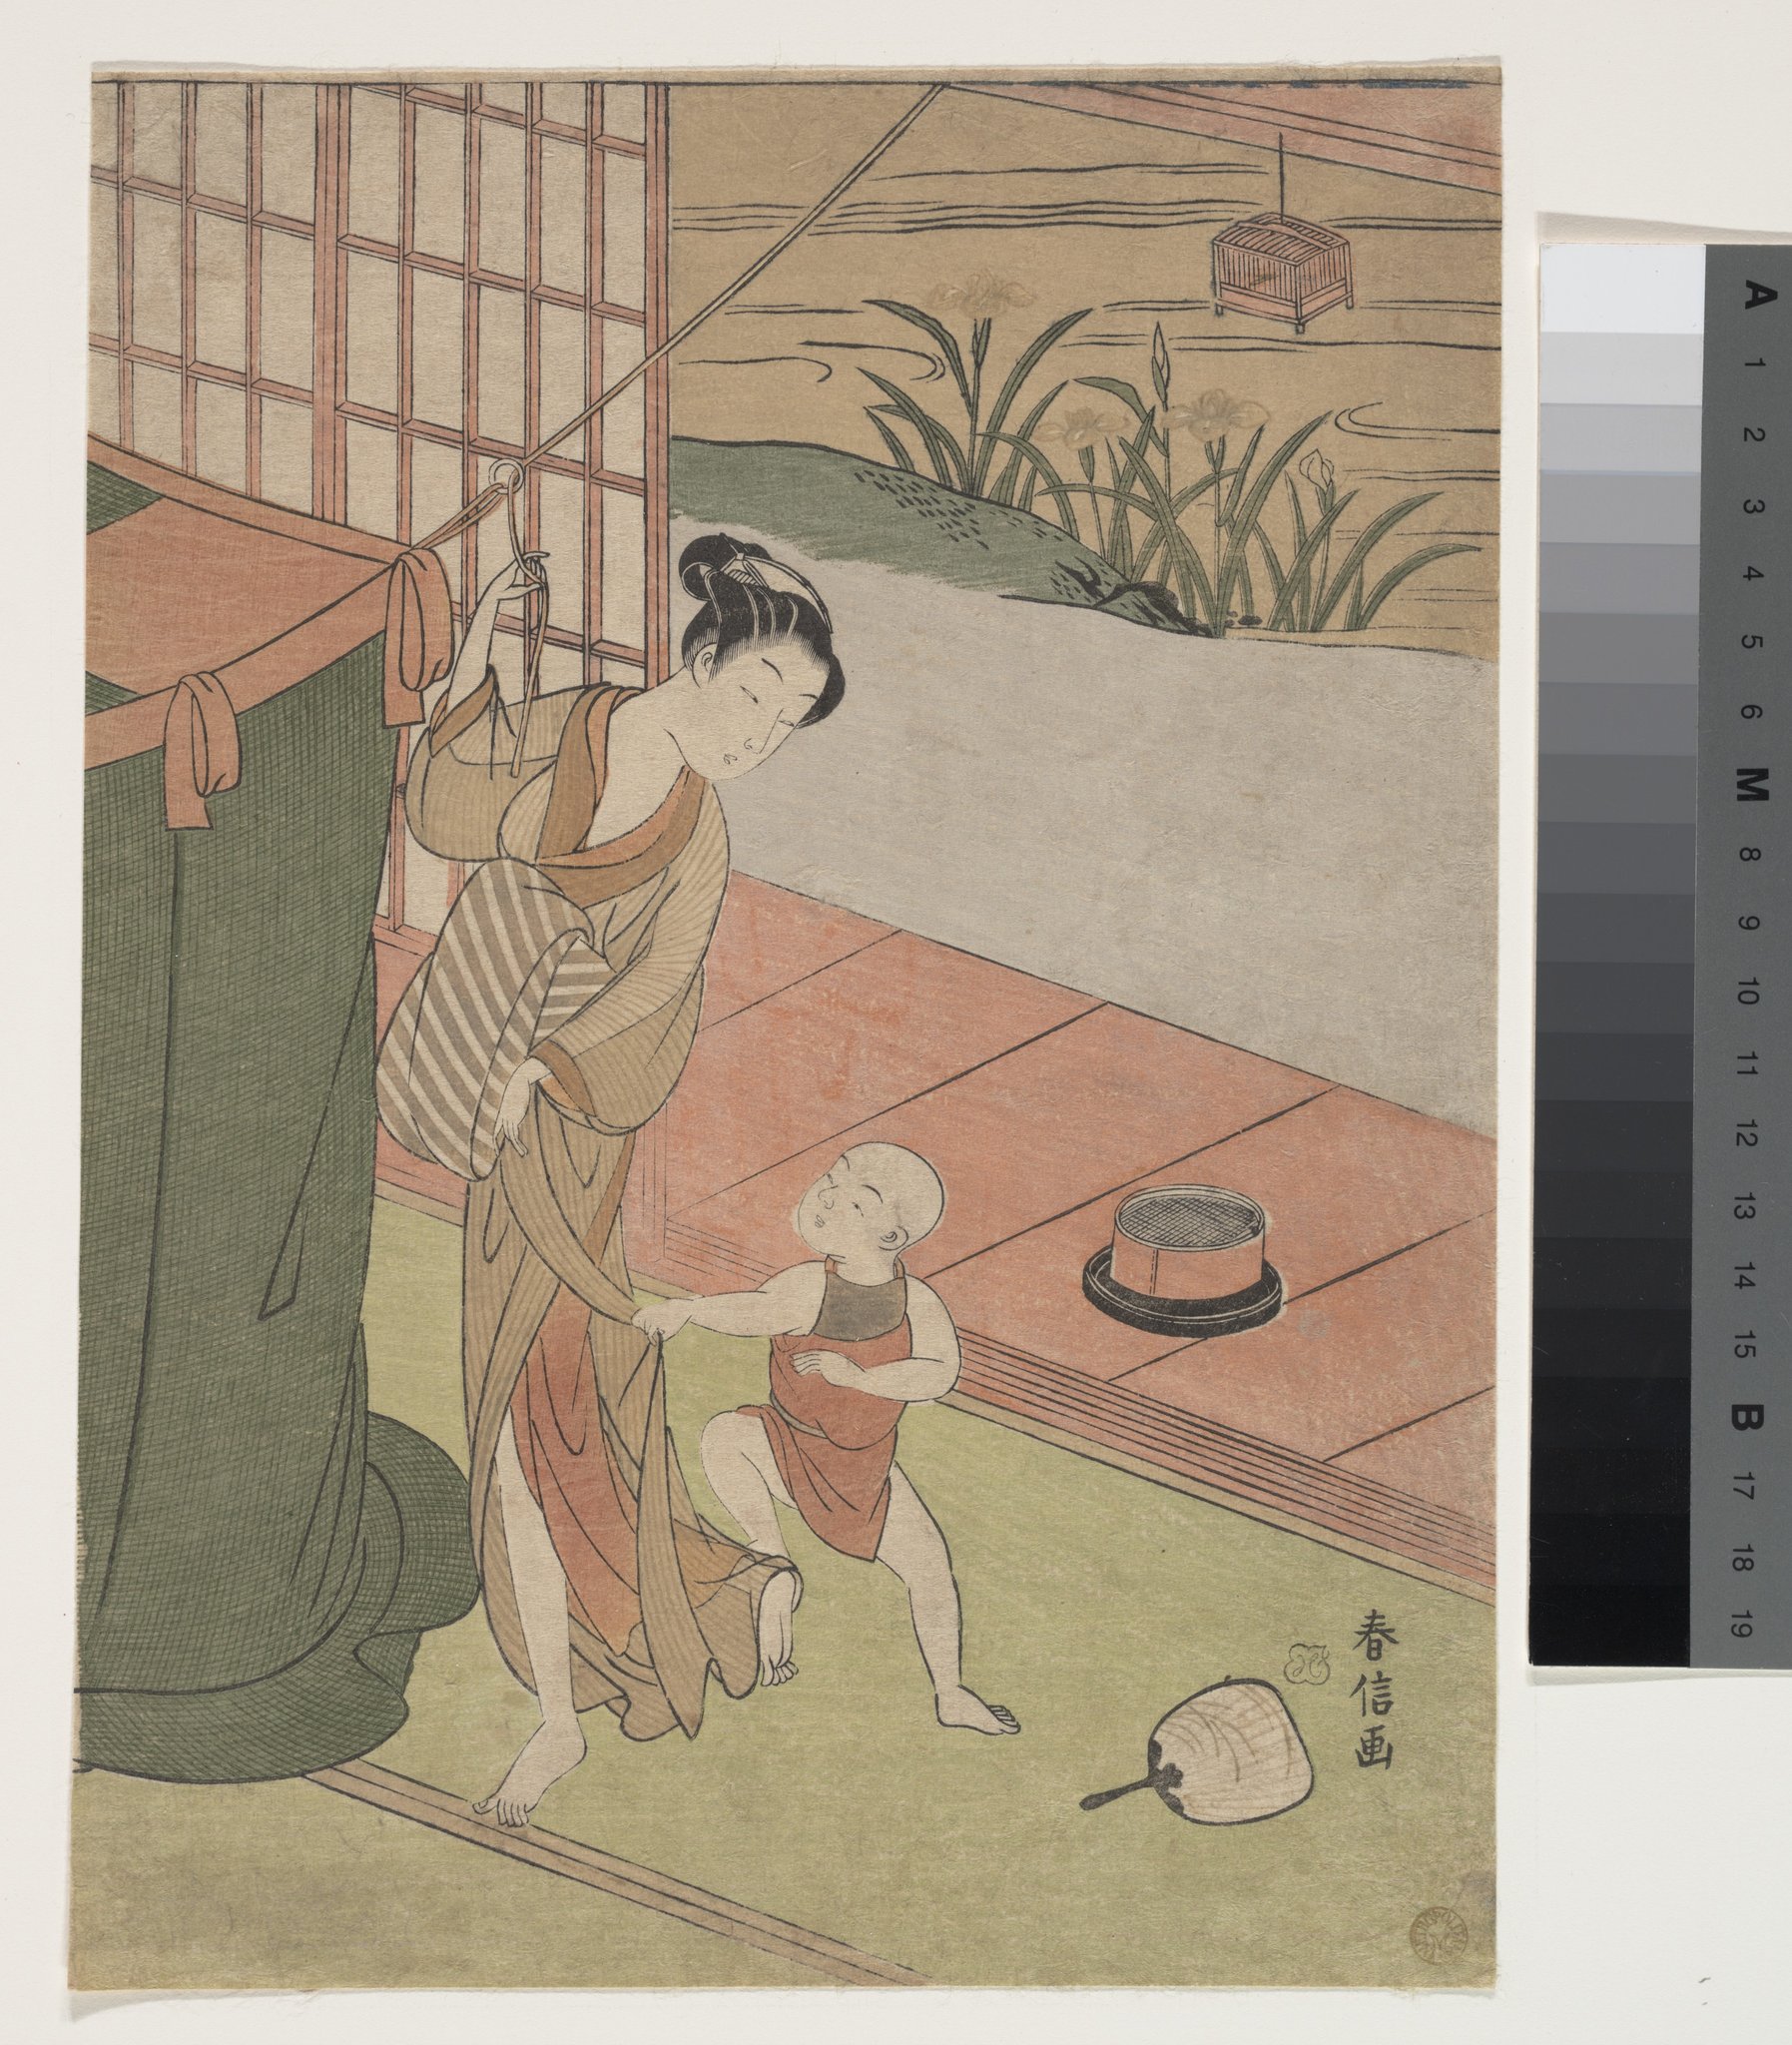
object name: print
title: Mother and Son by a Mosquito Net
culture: japanese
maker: suzuki harunobu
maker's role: artist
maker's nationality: japanese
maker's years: 1725-1770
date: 1769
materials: ink, paper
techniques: woodblock print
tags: children,mothers